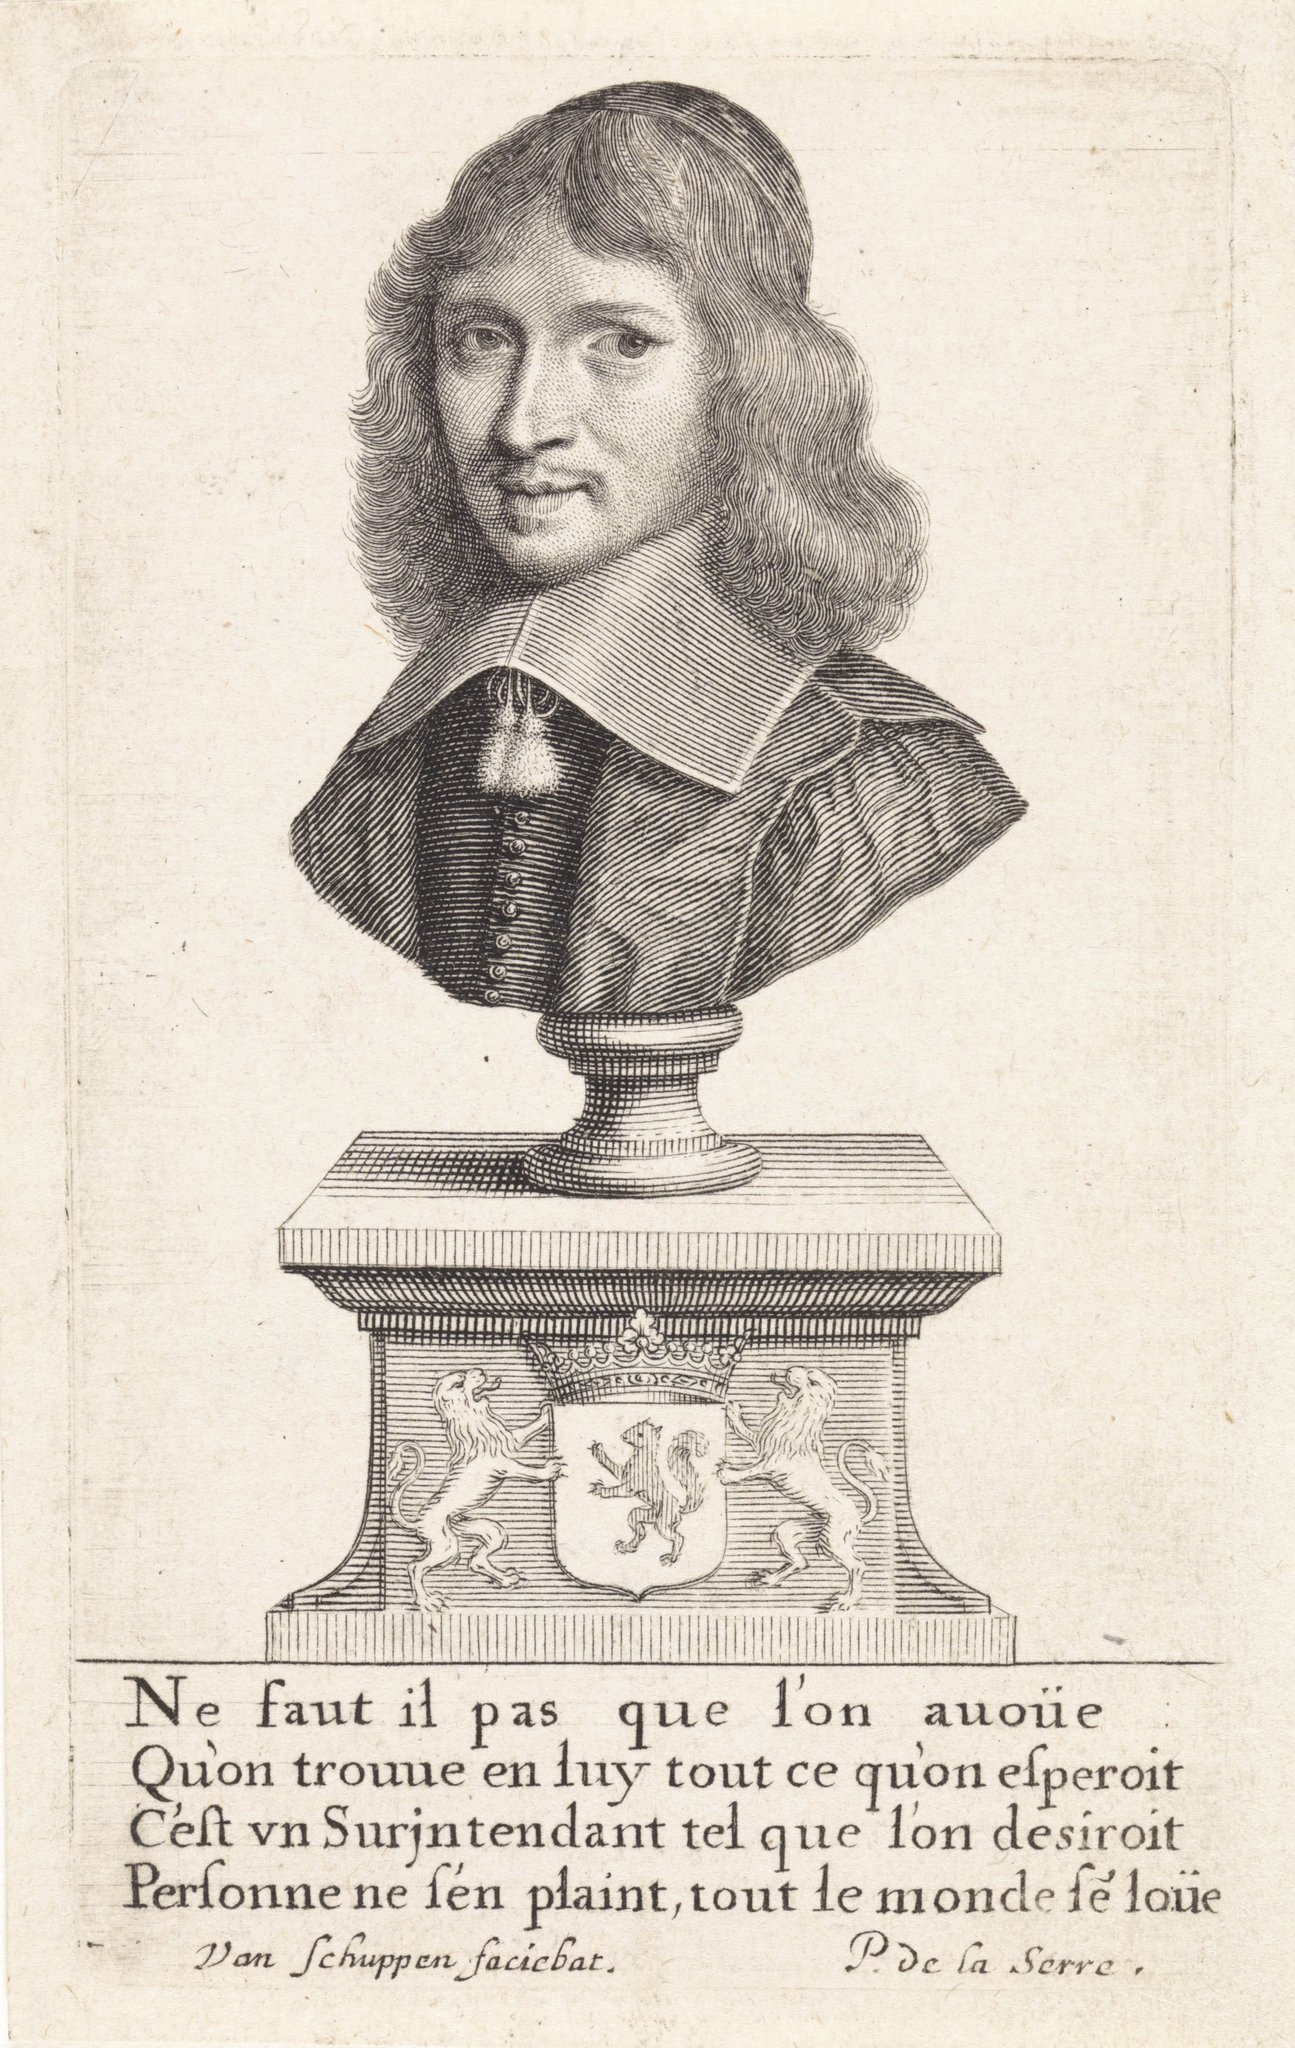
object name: print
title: Portret van Nicolas Foucquet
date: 1655-1703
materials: paper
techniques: engraving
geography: paris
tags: paris, france, politician, nicolas fouquet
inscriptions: inscription: ‘Nicolas Foucquet, Vicomte de Melun et de Vaux, Marquis de Belle-Isle sur Intendant des Finances, 1615-1680.’, collector's mark: Lugt 2228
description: Portret van Nicolas Foucquet, burggraaf van Melun en Vaux, in de vorm van een buste op een piëdestal. Op het voetstuk staat zijn wapenschild met de klimmende eekhoorn met aan weerszijden twee leeuwen als schilddragers. Onder de afbeelding een lofdicht in het Frans op de kwaliteiten van Foucquet als Surintendant van Financiën.